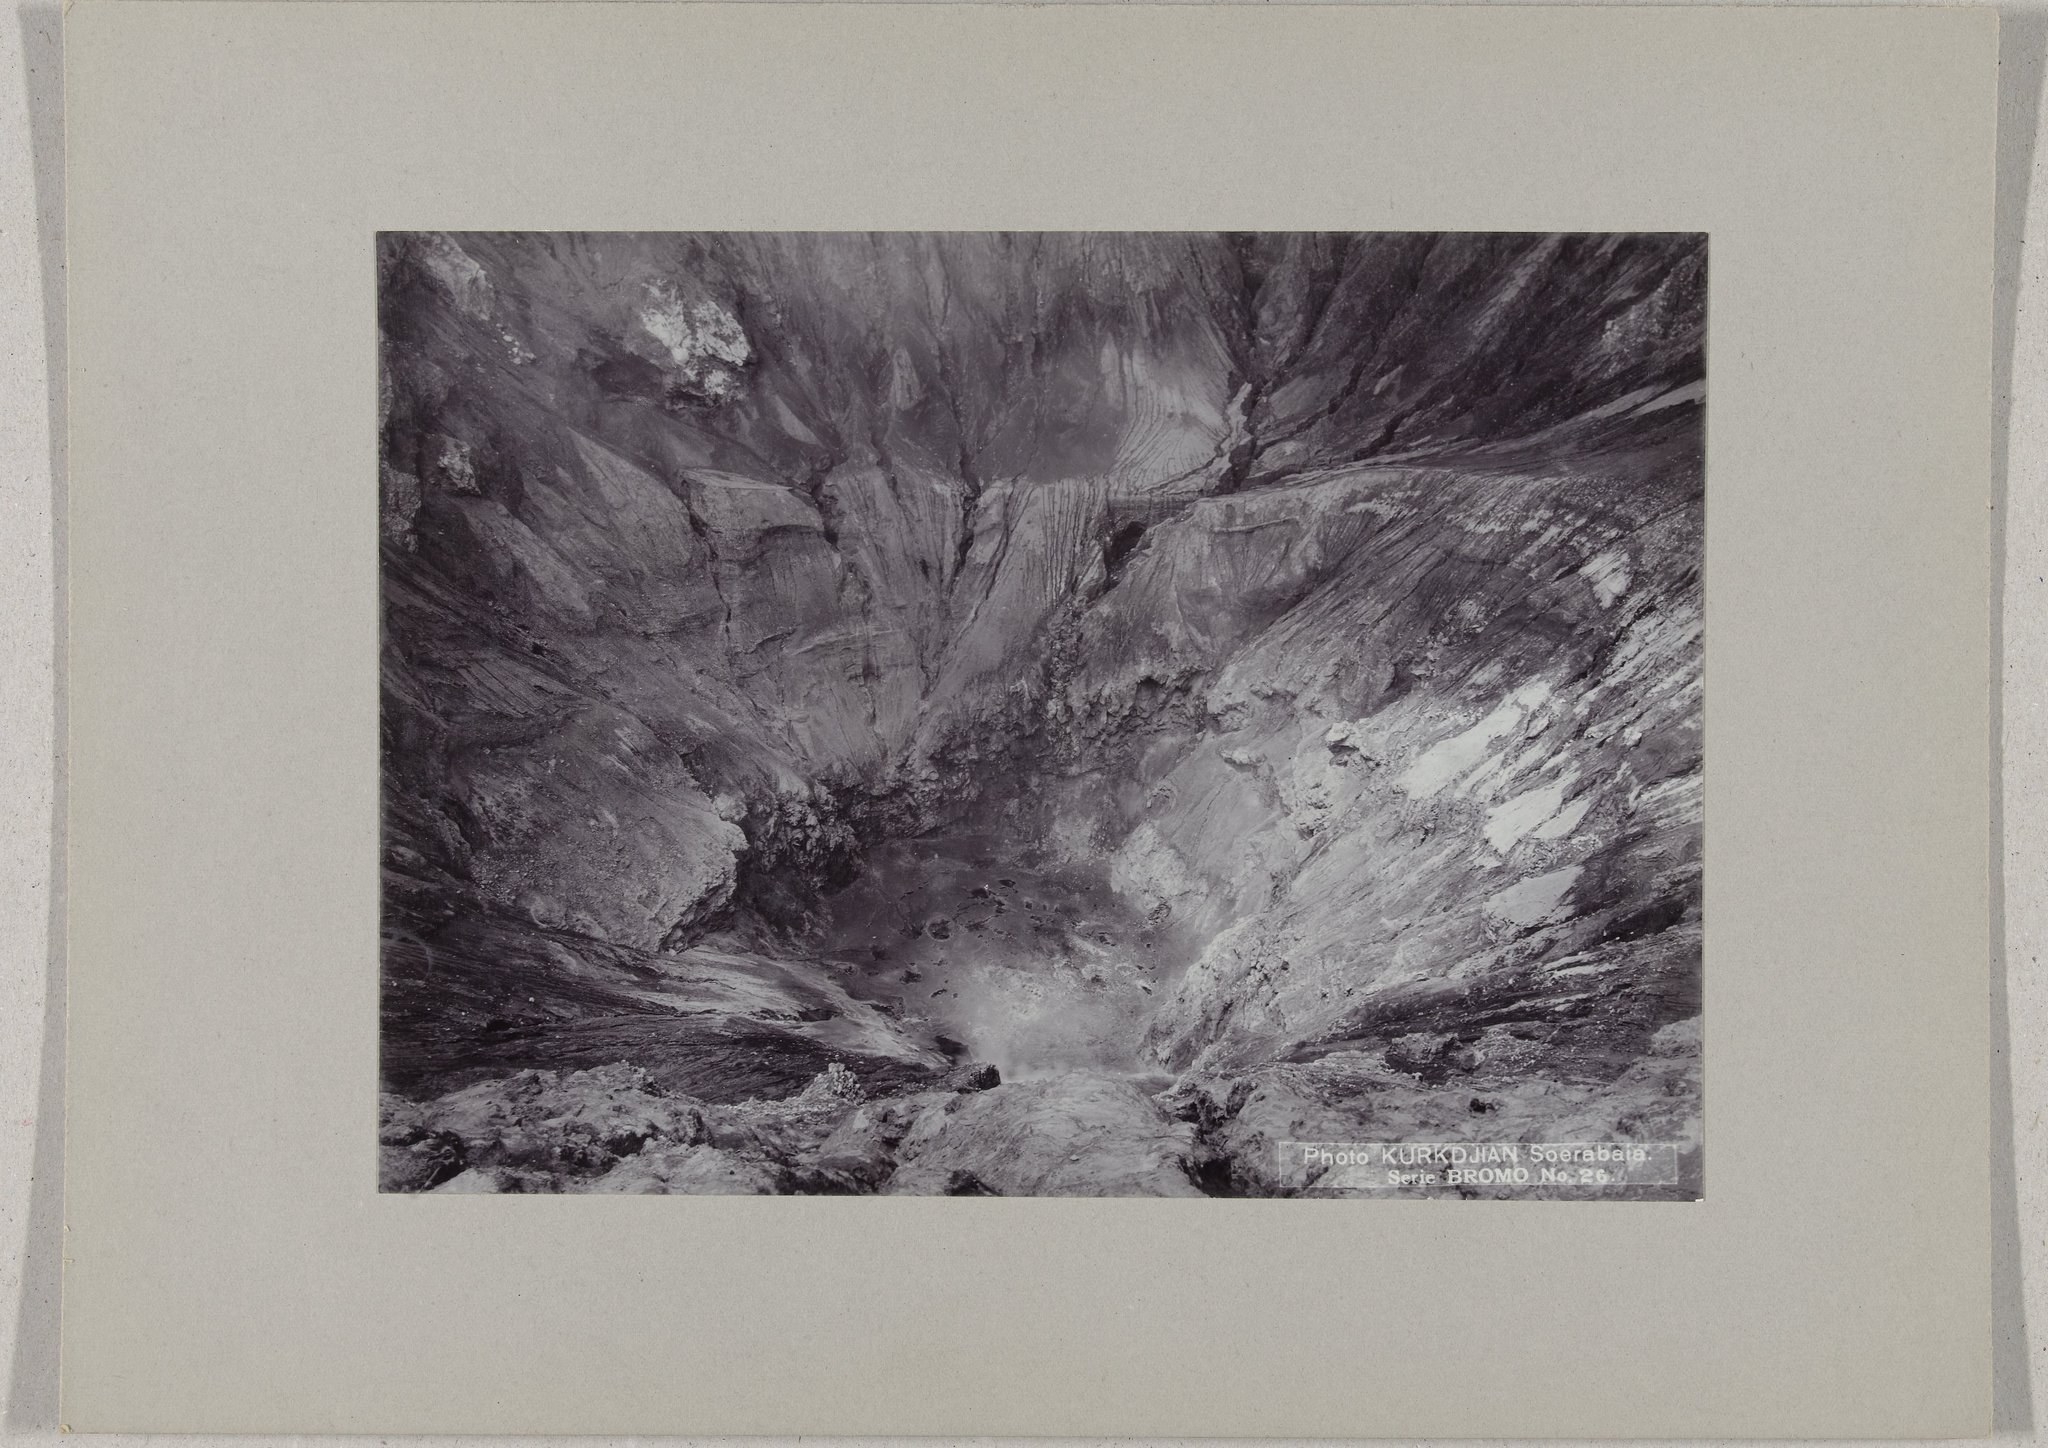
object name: photograph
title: Krater van de vulkaan Bromo, Java, Nederlands-Indië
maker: onnes kurkdjian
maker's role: fotograaf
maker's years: 1851-1903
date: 1895-1915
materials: cardboard, paper, photographic support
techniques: gelatin silver print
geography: java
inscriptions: number: ‘93’, name: ‘Photo Kurkdjian Soerabaia / Serie Bromo No. 26’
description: Krater van de vulkaan Bromo, Java, Nederlands-Indië